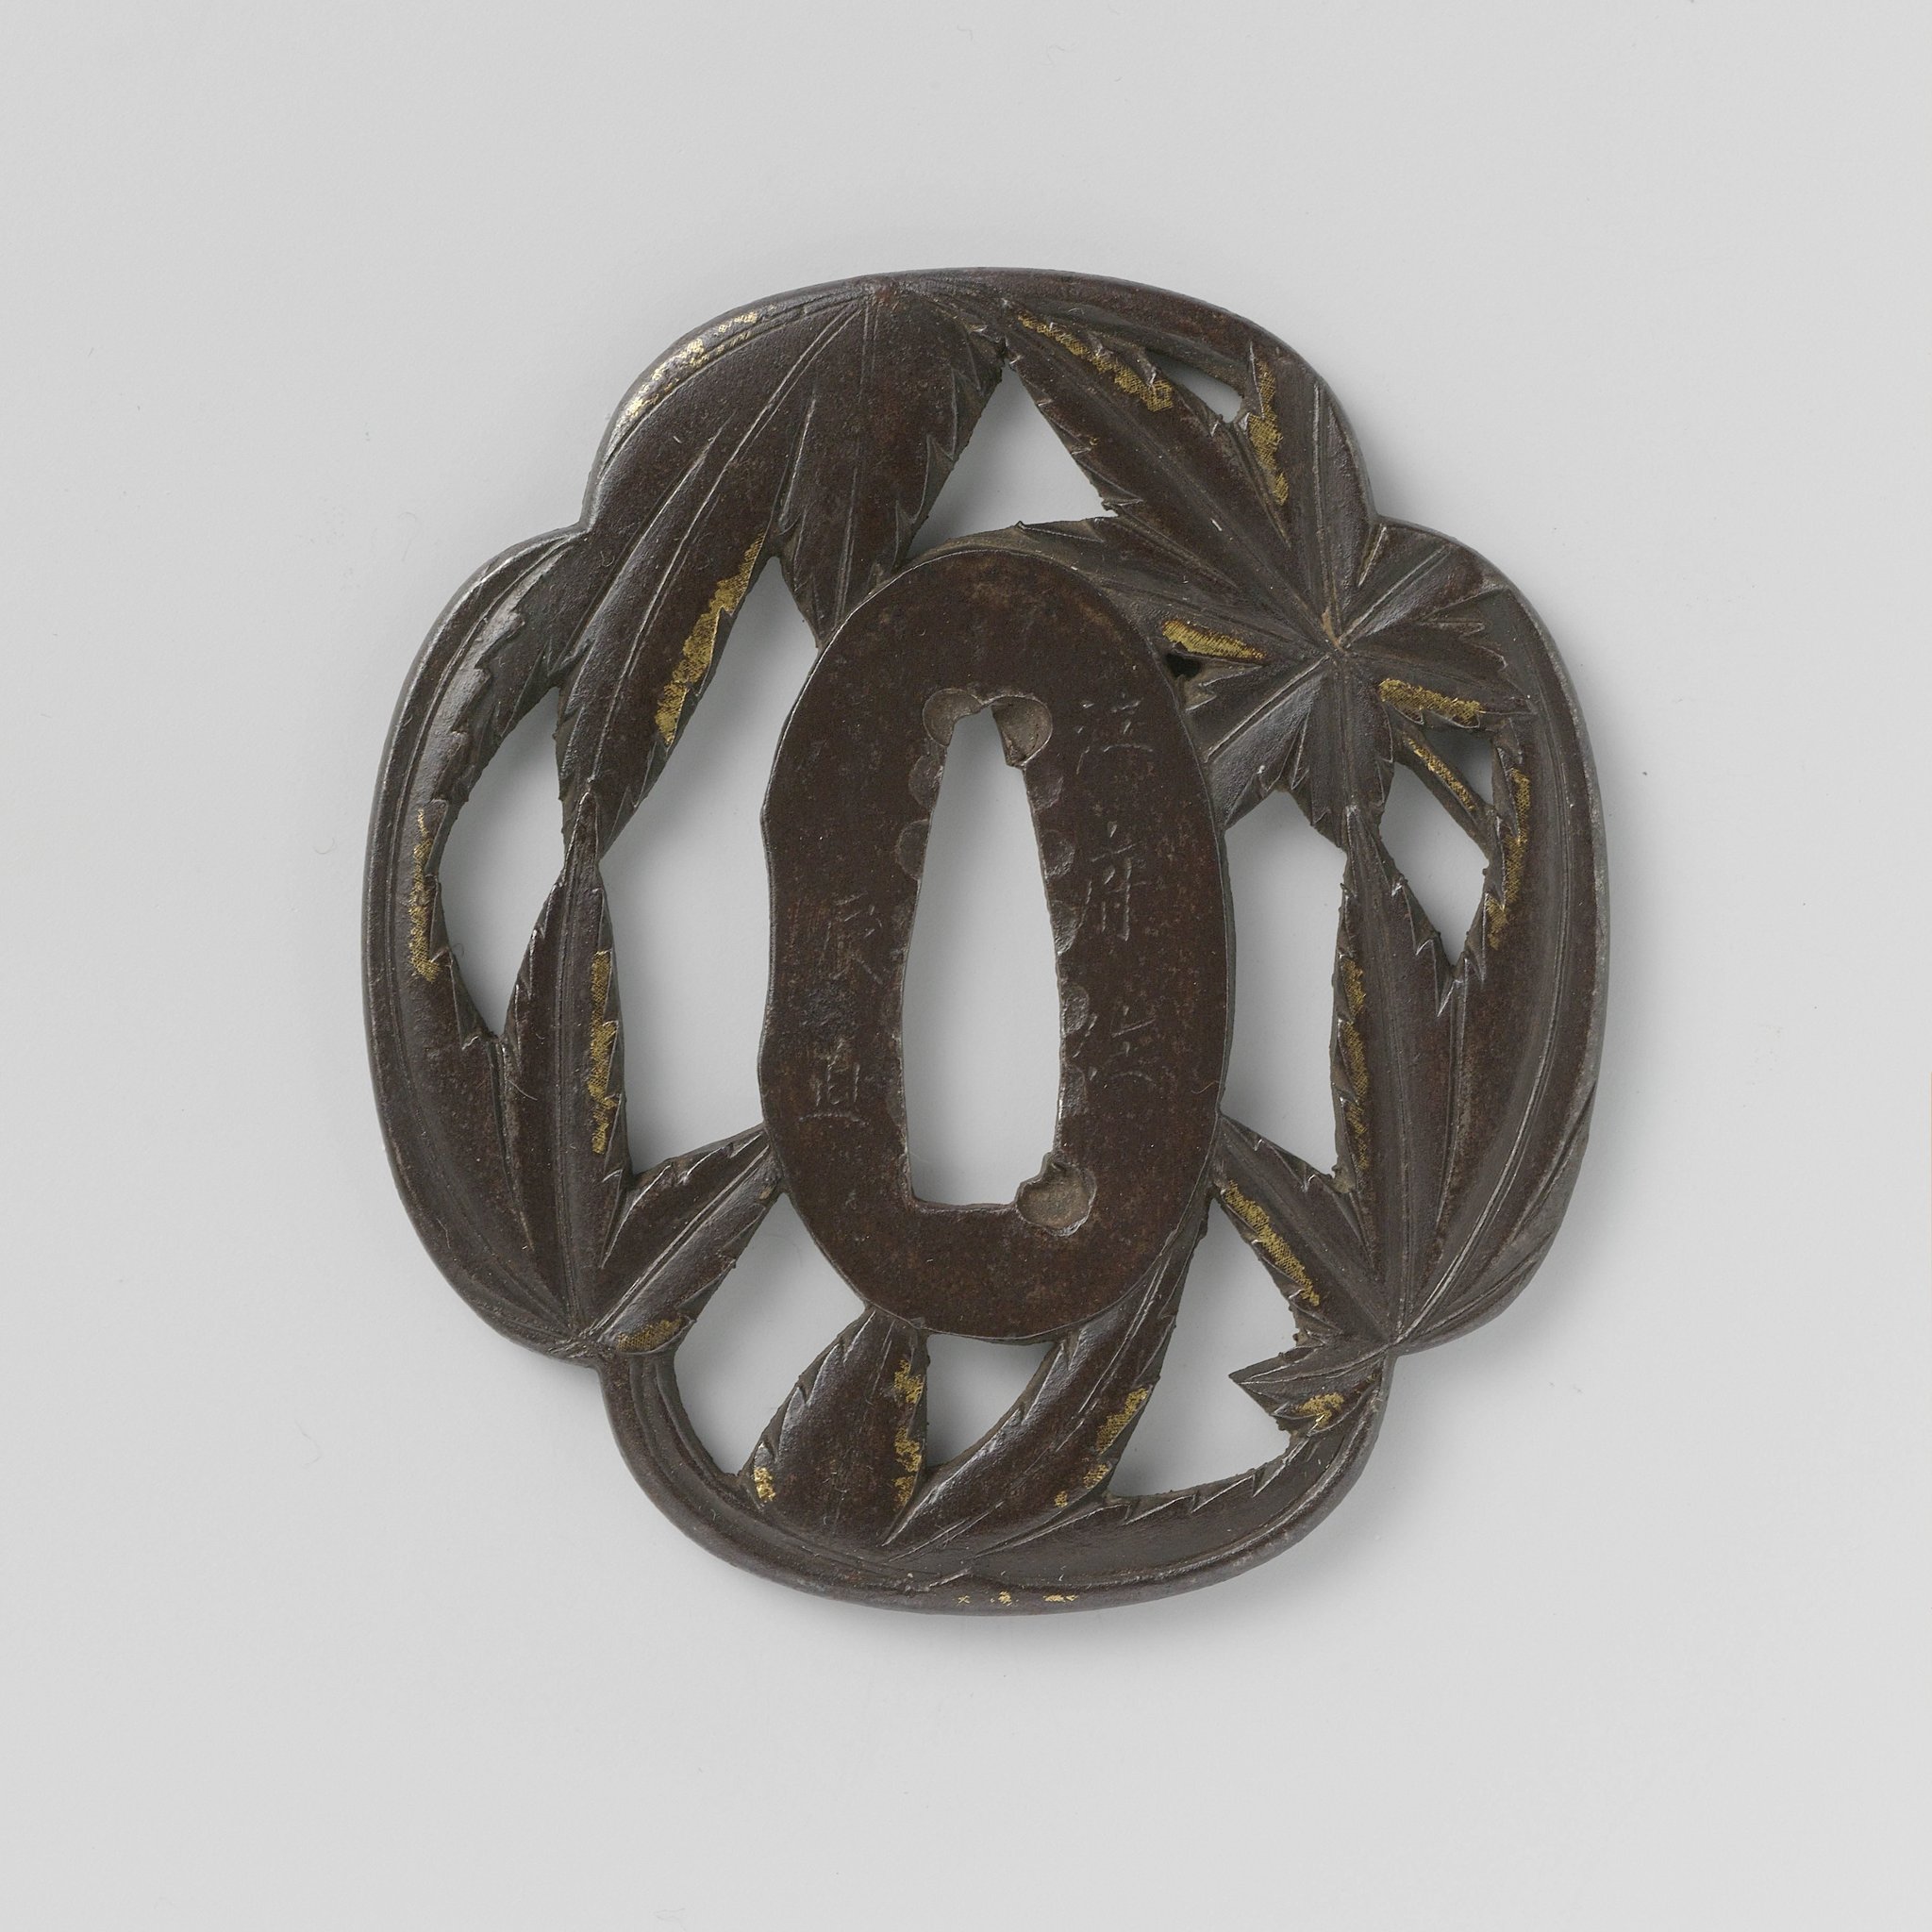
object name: tsuba, zwaardstootplaat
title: Hand guard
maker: tokinao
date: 1700-1900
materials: gold, iron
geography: japan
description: Mokko-vormige tsuba, opengewerkt, opgebouwd uit bladeren met enkele details in goud (nunome-zogan); gesigneerd "koju ju tokinao".